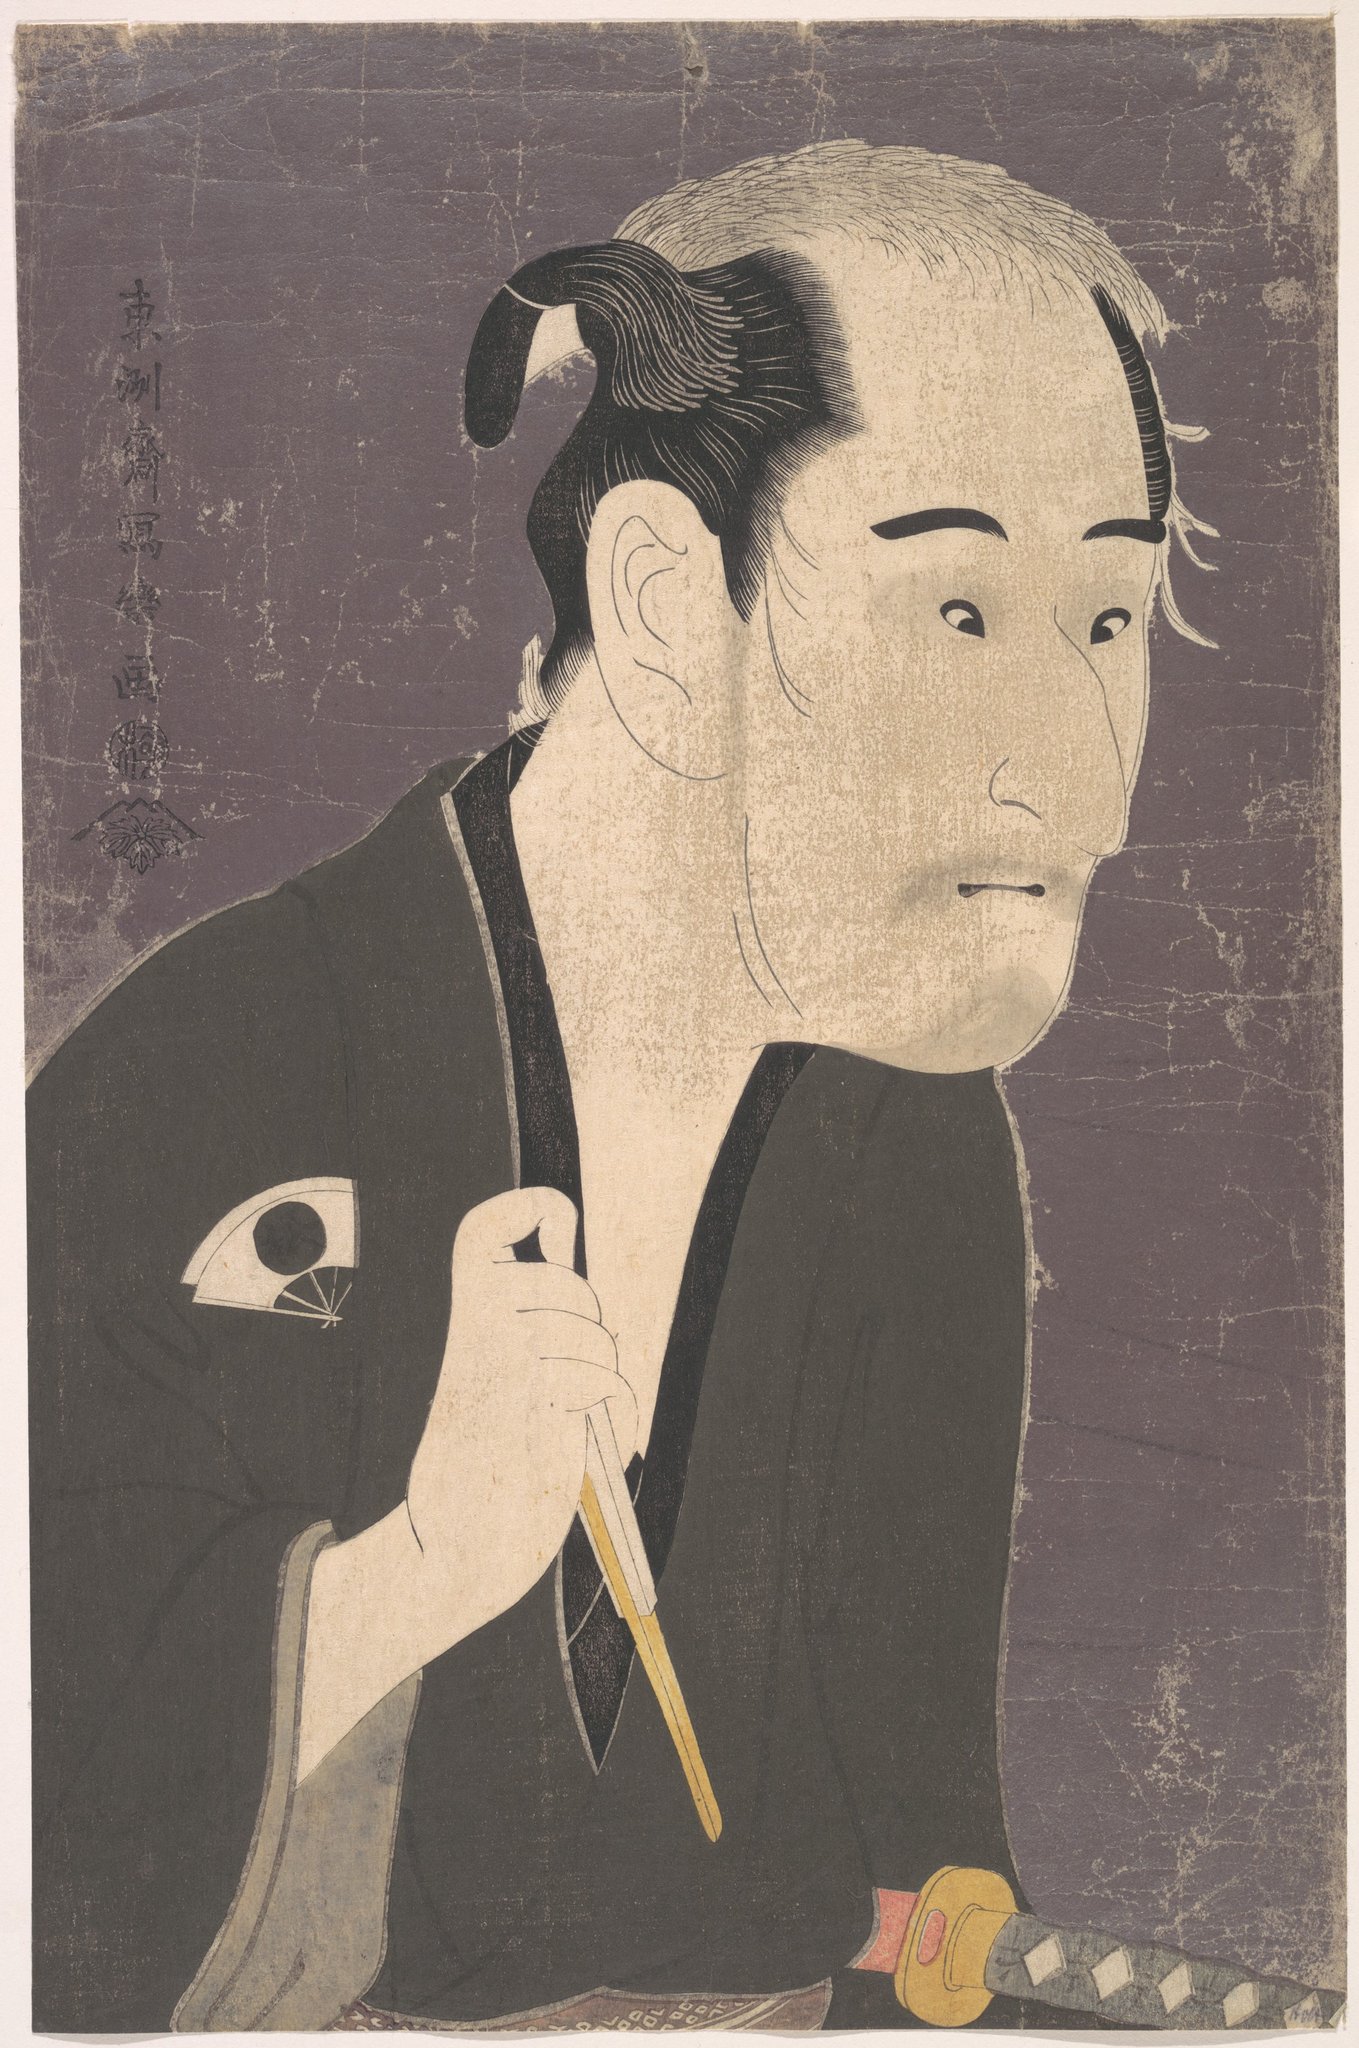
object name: print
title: The Actor Onoye Matsusuke as a Ronin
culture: japanese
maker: tōshūsai sharaku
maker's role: artist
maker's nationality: japanese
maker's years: 1794-1795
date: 1749-1795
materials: ink, paper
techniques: woodblock print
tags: men,actors